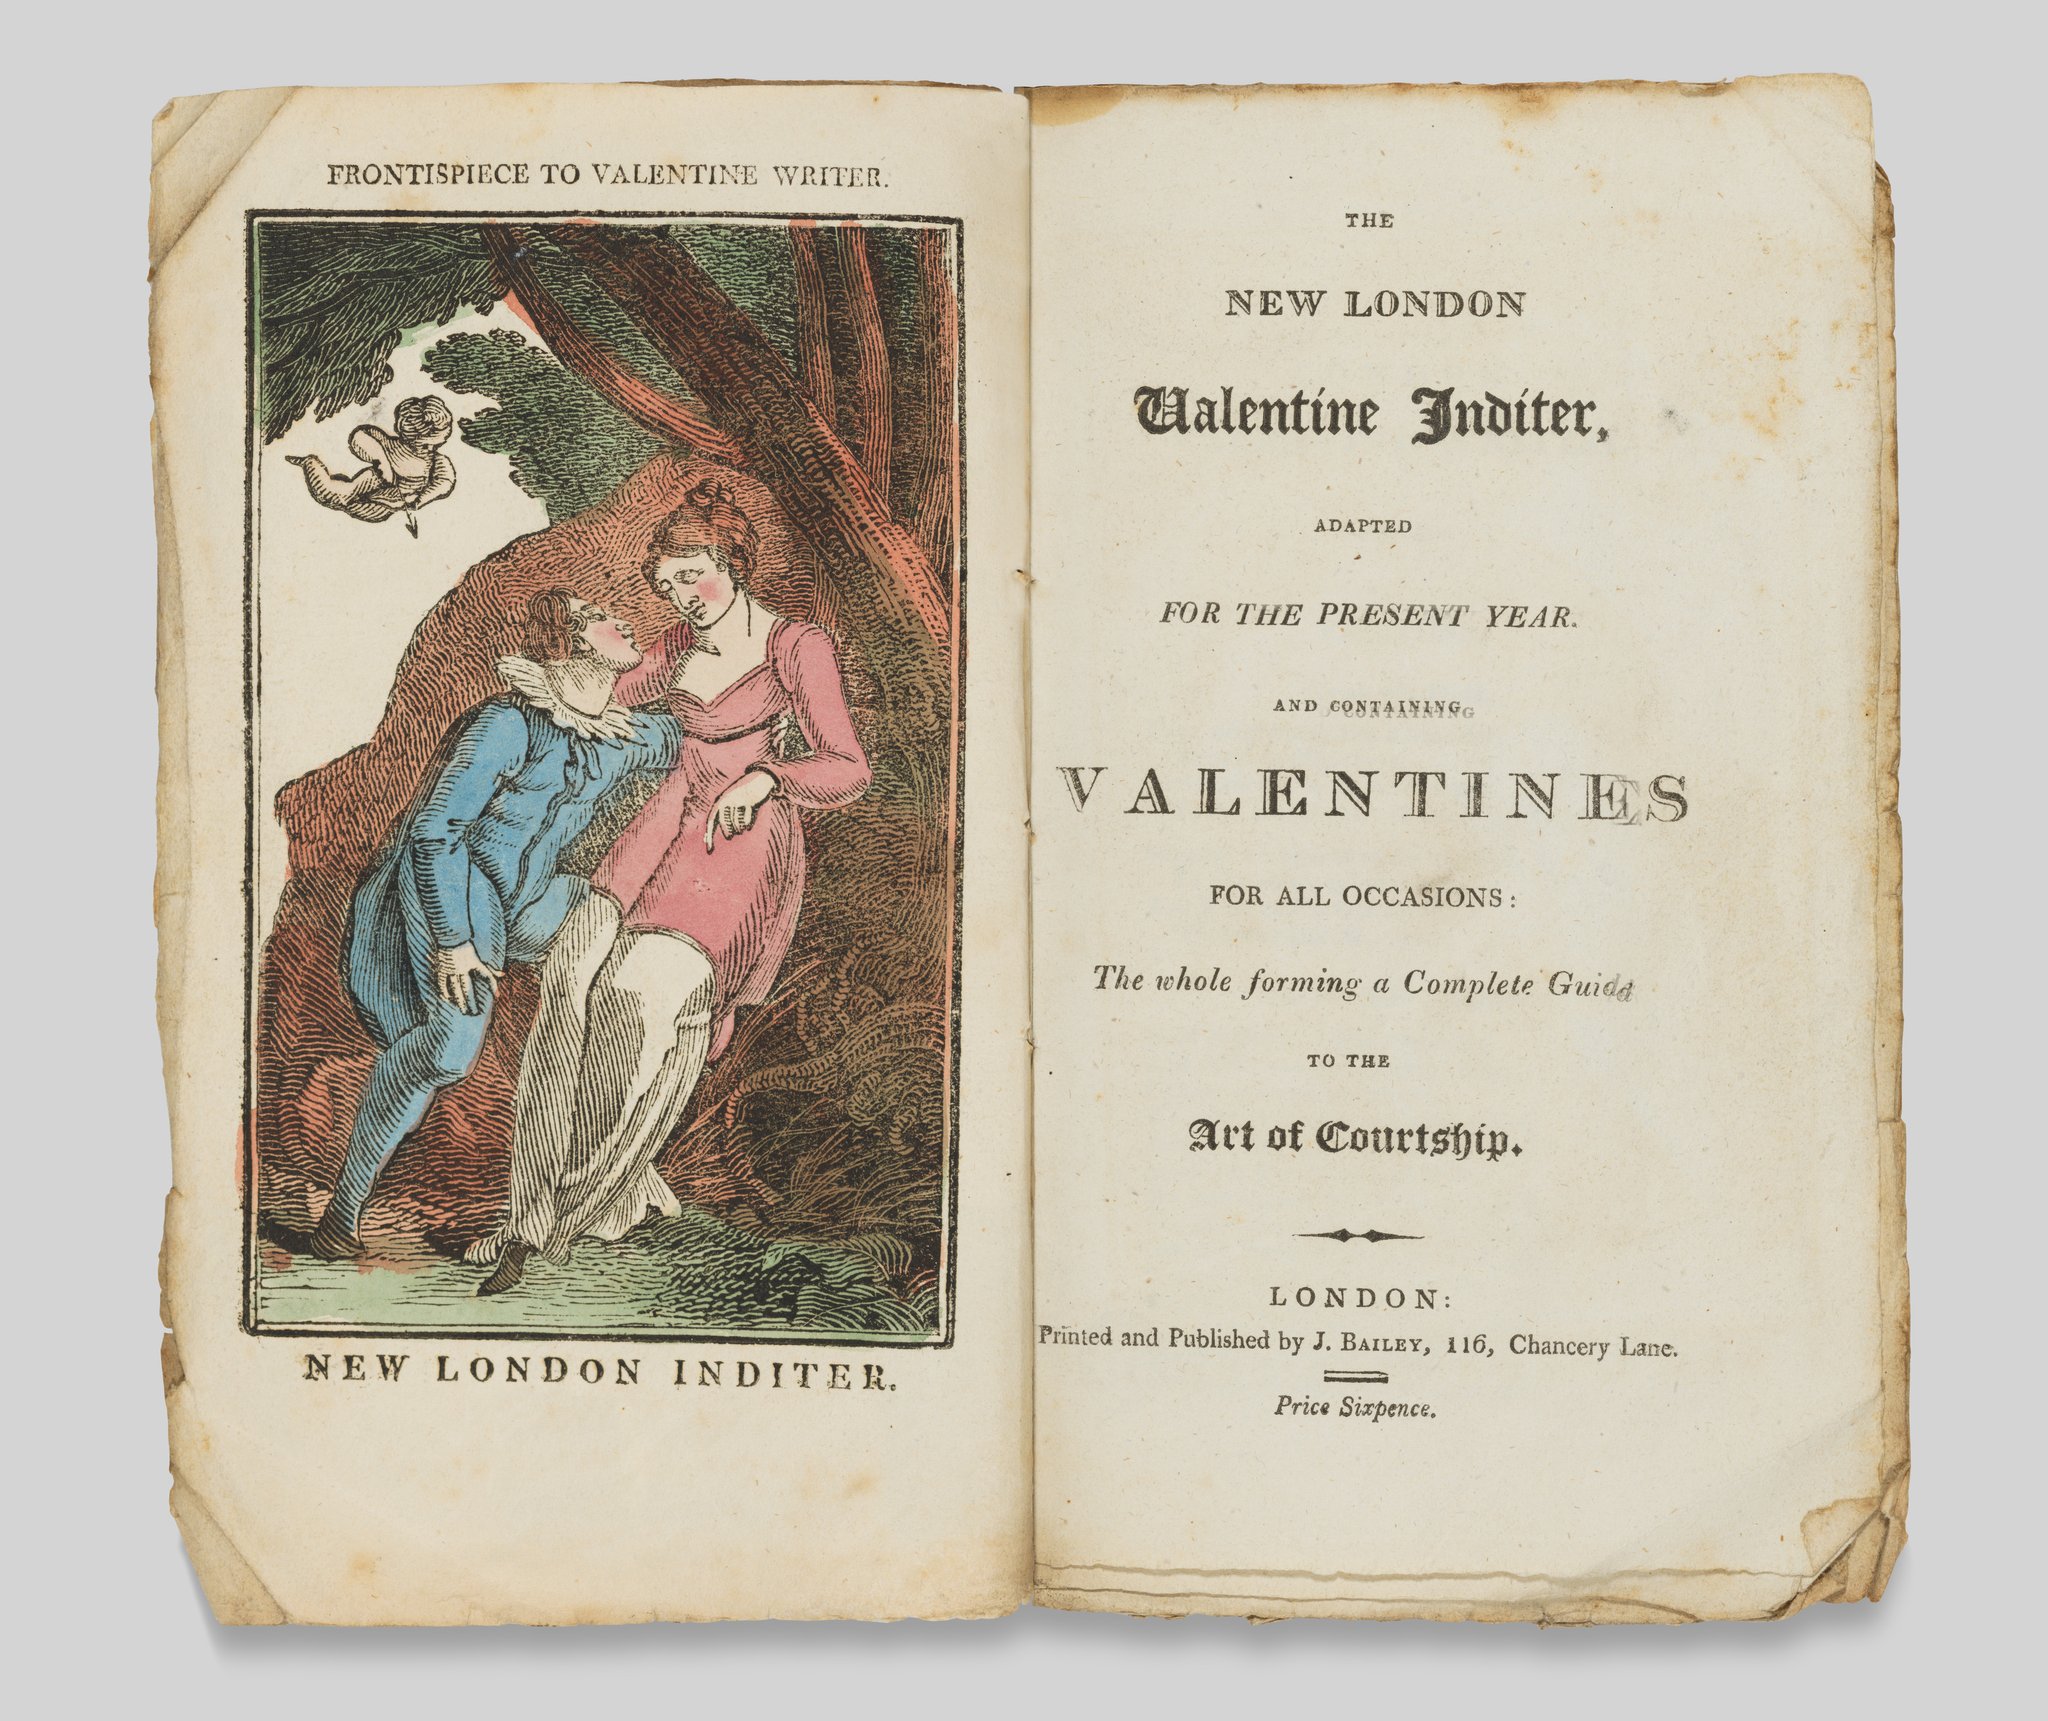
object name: pamphlet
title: The New London Valentine Inditer Adapted for the Present Year, and Containing Valentines for All Occasions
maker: j. bailey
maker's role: publisher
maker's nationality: british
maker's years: 1800-1900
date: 1808-1824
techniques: hand coloring, engraving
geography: england